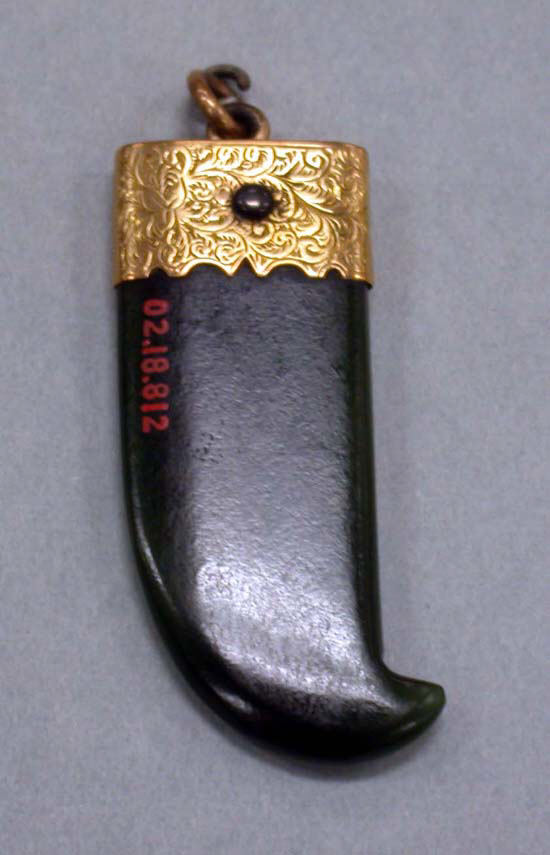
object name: pendant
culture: new zealander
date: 1801-1900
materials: jade